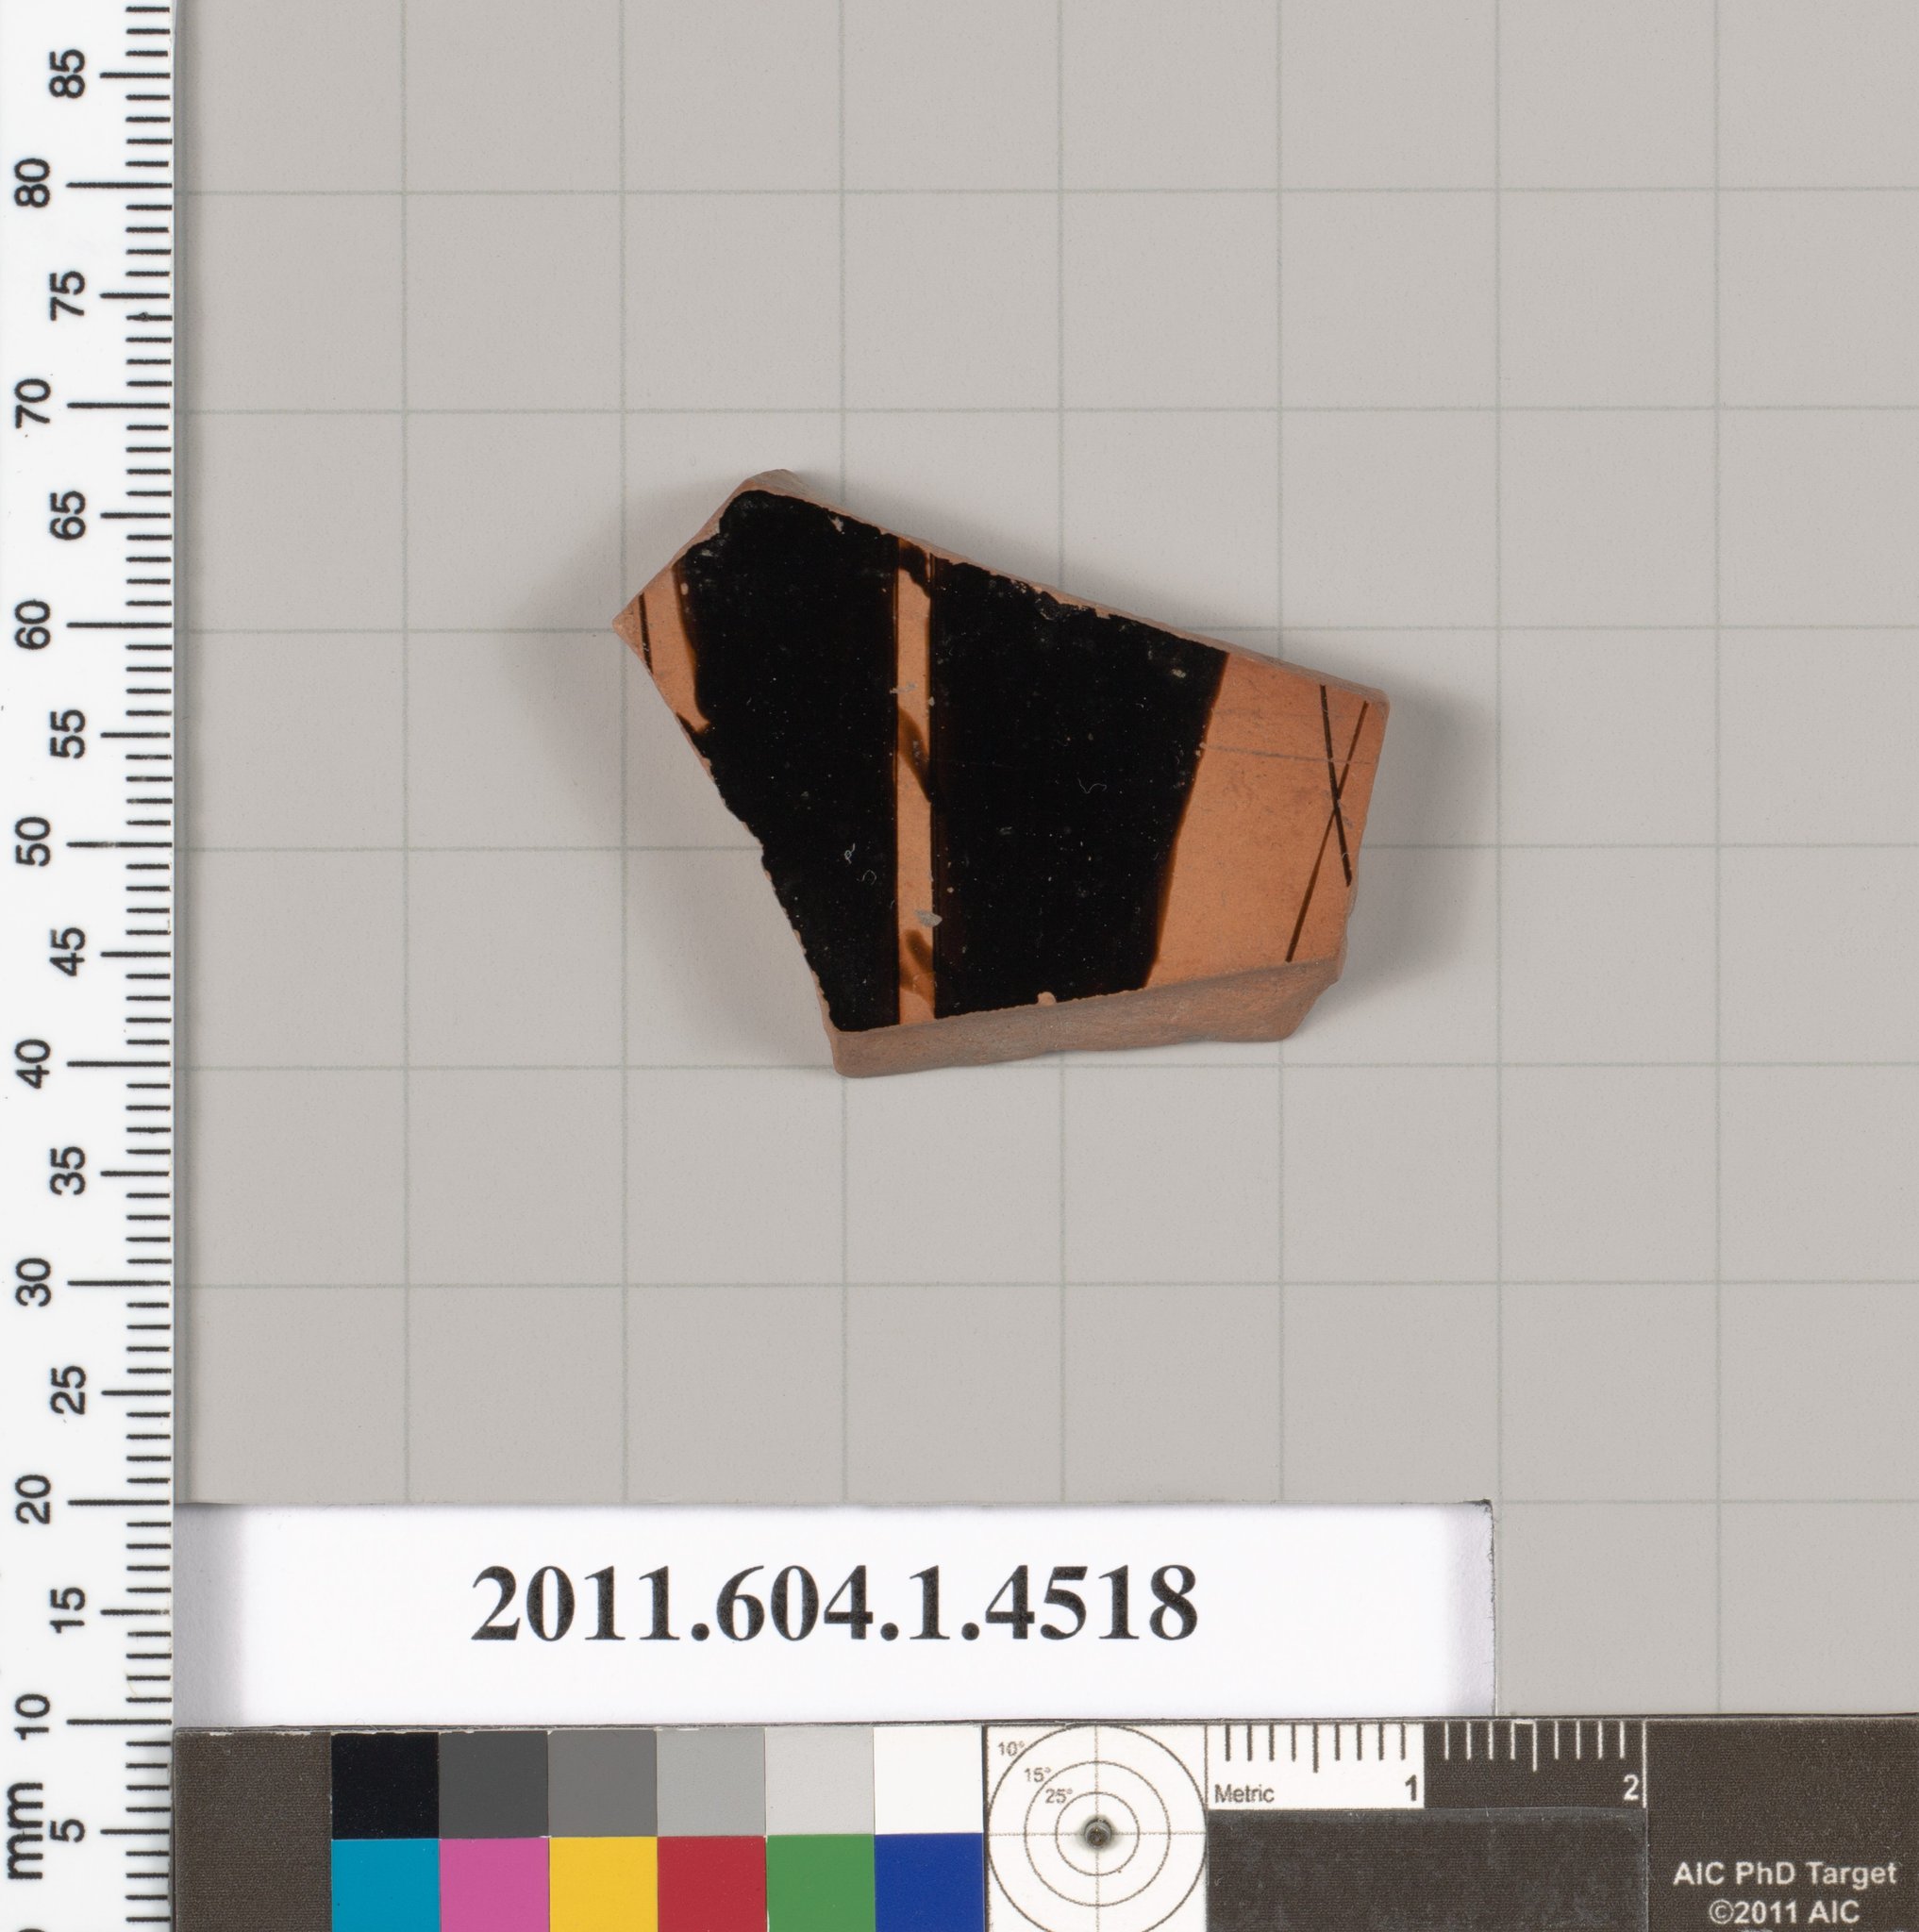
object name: kylix fragment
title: Terracotta fragment of a kylix (drinking cup)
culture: greek, attic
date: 475-451 BCE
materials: terracotta